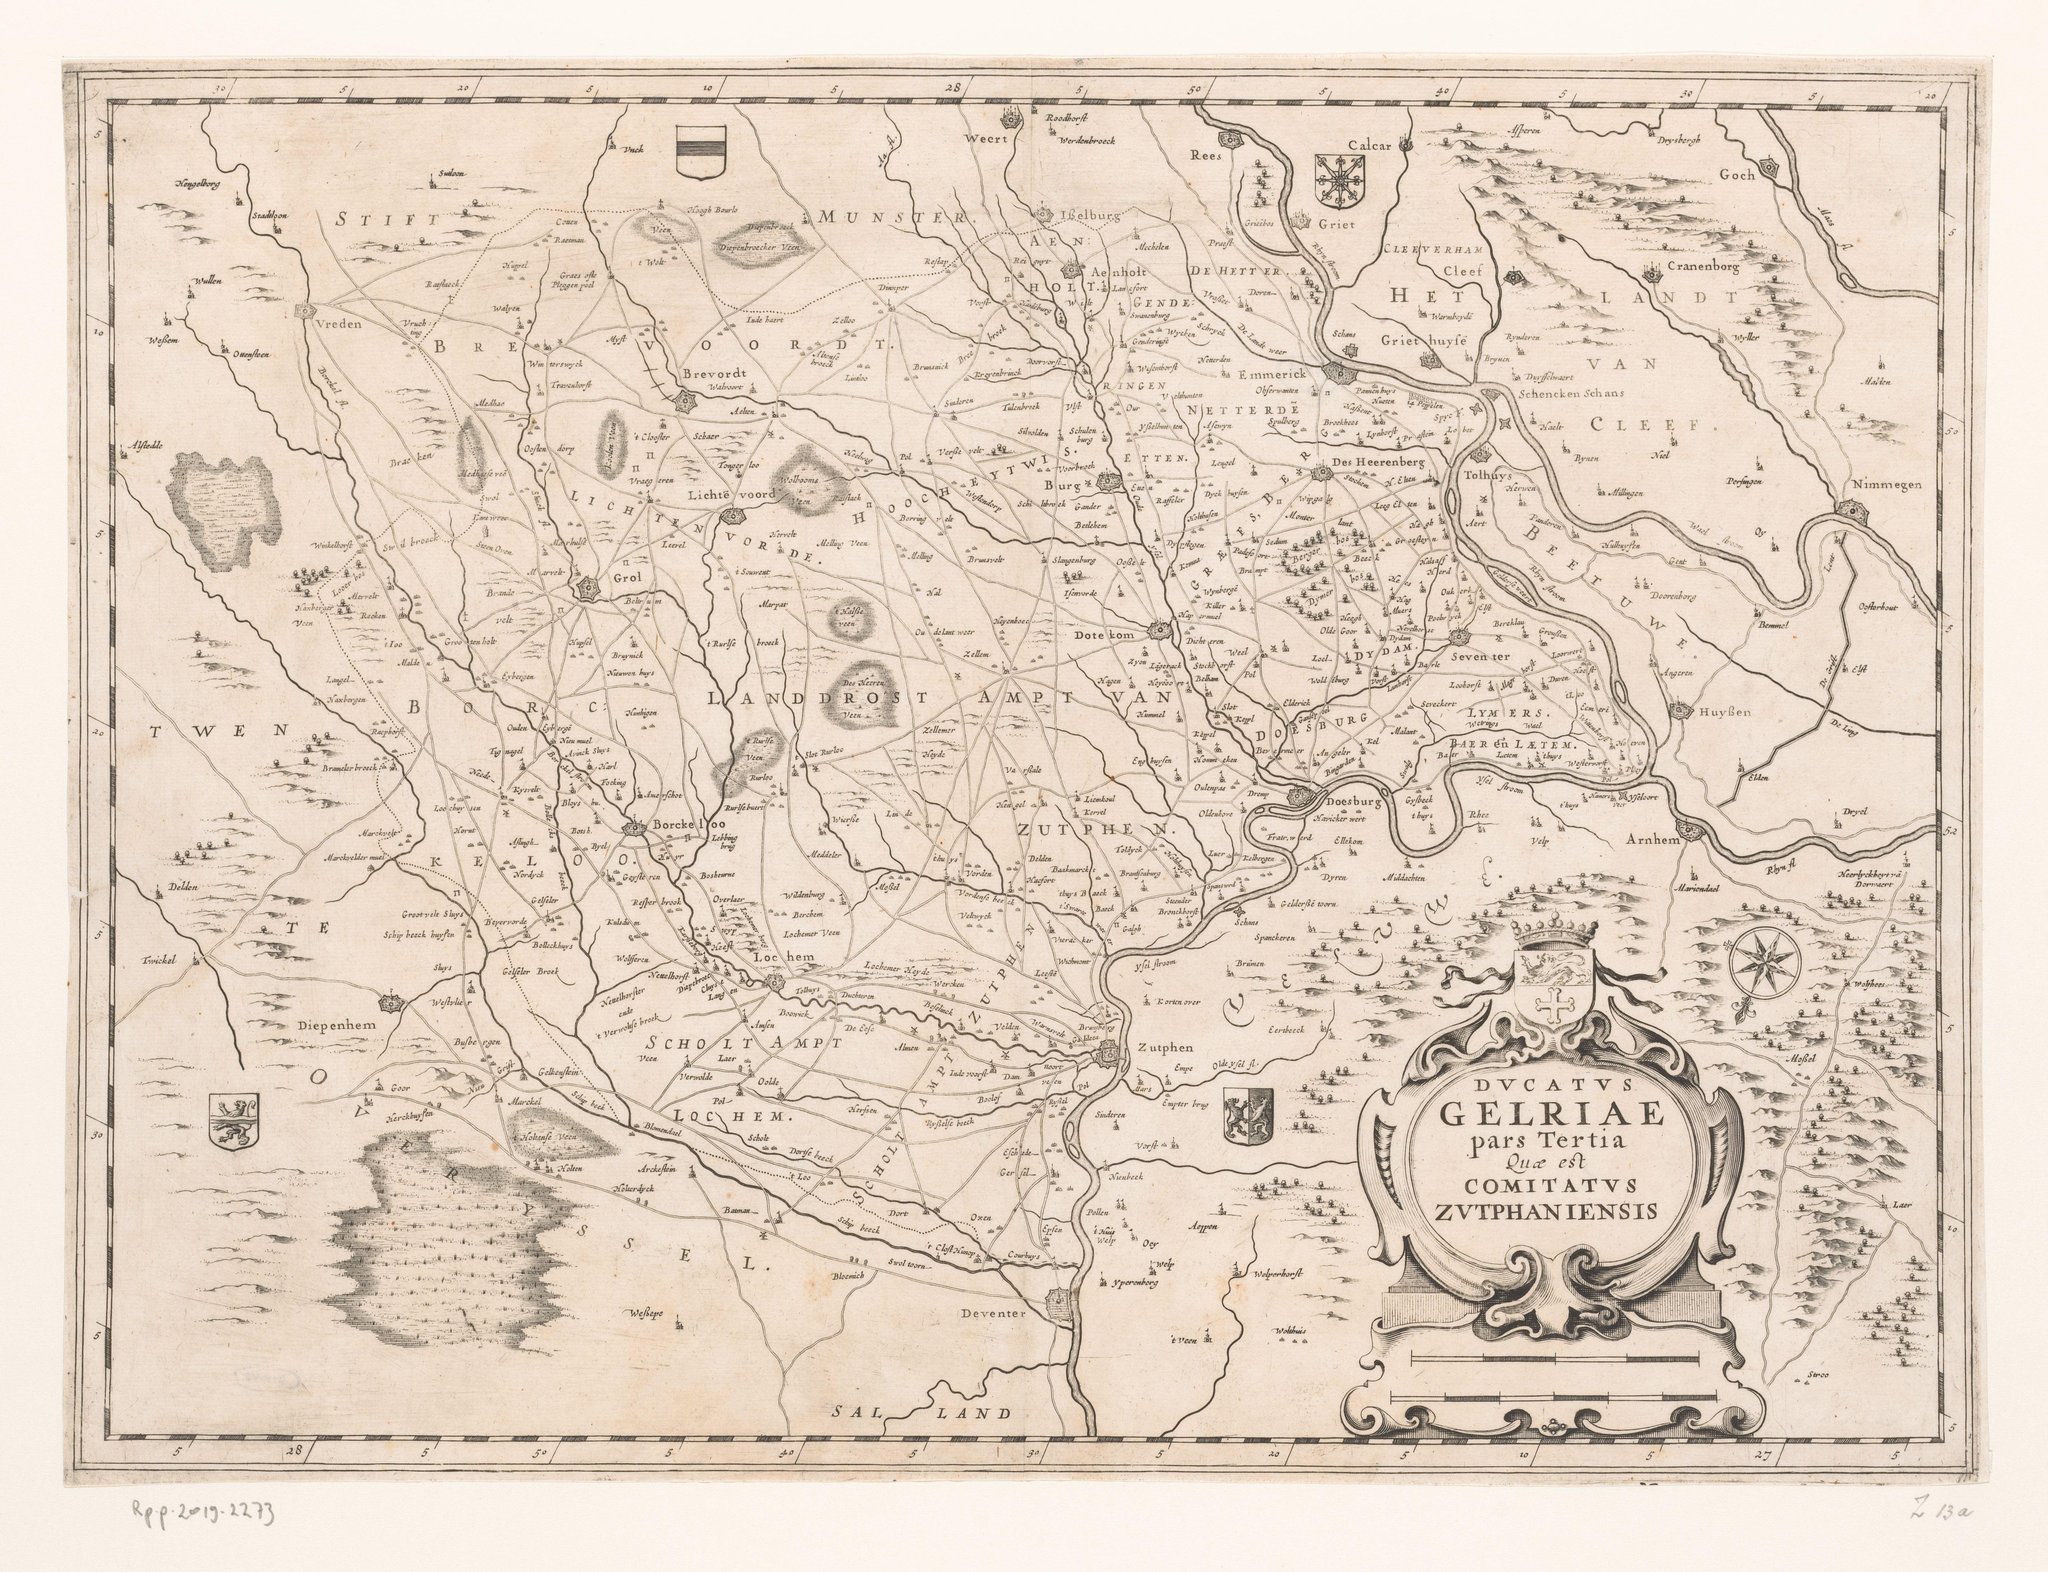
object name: map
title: Ducatus Gelriae pars tertia quae est comitatus Zutphaniensis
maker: Anonymous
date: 1641-1680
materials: paper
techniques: engraving, etching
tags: coat of arms (as symbol of the state, etc.) (+ city; municipal), maps of separate countries or regions, gelderland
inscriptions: collector's mark: Lugt 2228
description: Rechtsonder de titelcartouche, met bovenin het wapen van de stad Zutphen en onderin twee schaalstokken. De kaart is voorzien van een gradenverdeling langs de randen. Met Latijnse tekst op verso.